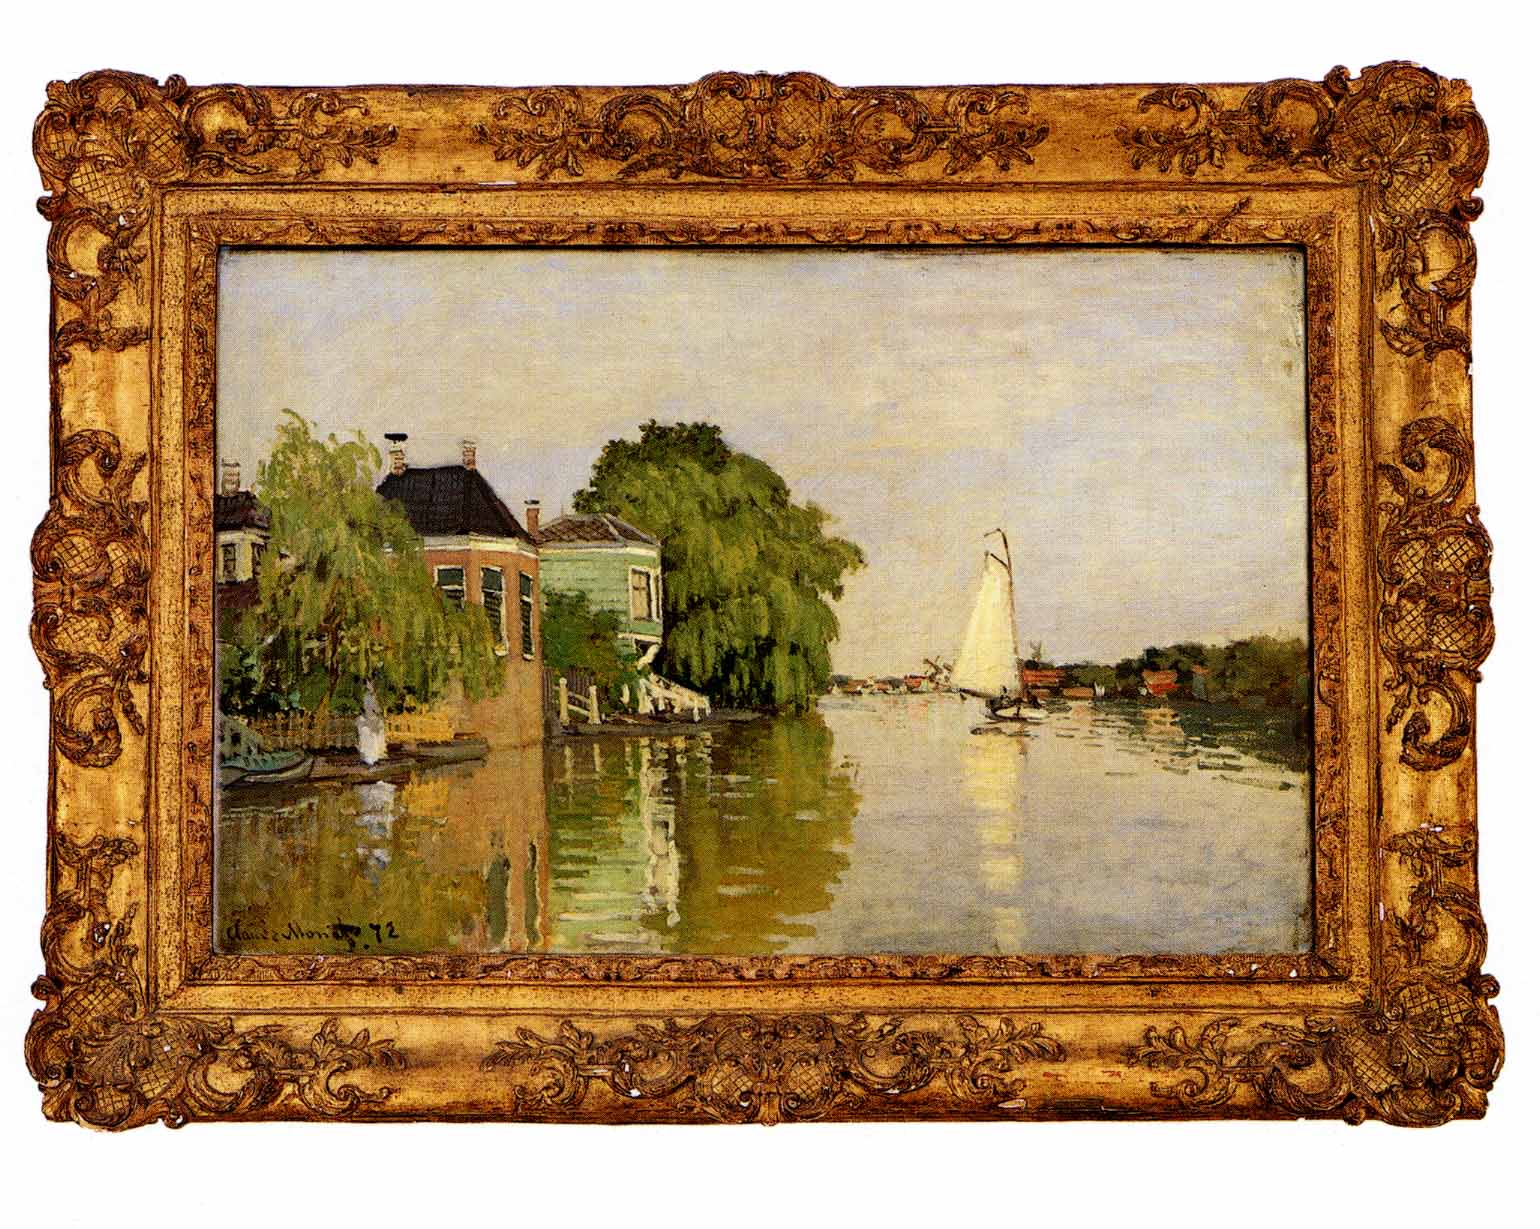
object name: frame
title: Ogee frame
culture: french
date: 1720-1730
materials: gilt, wood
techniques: carving